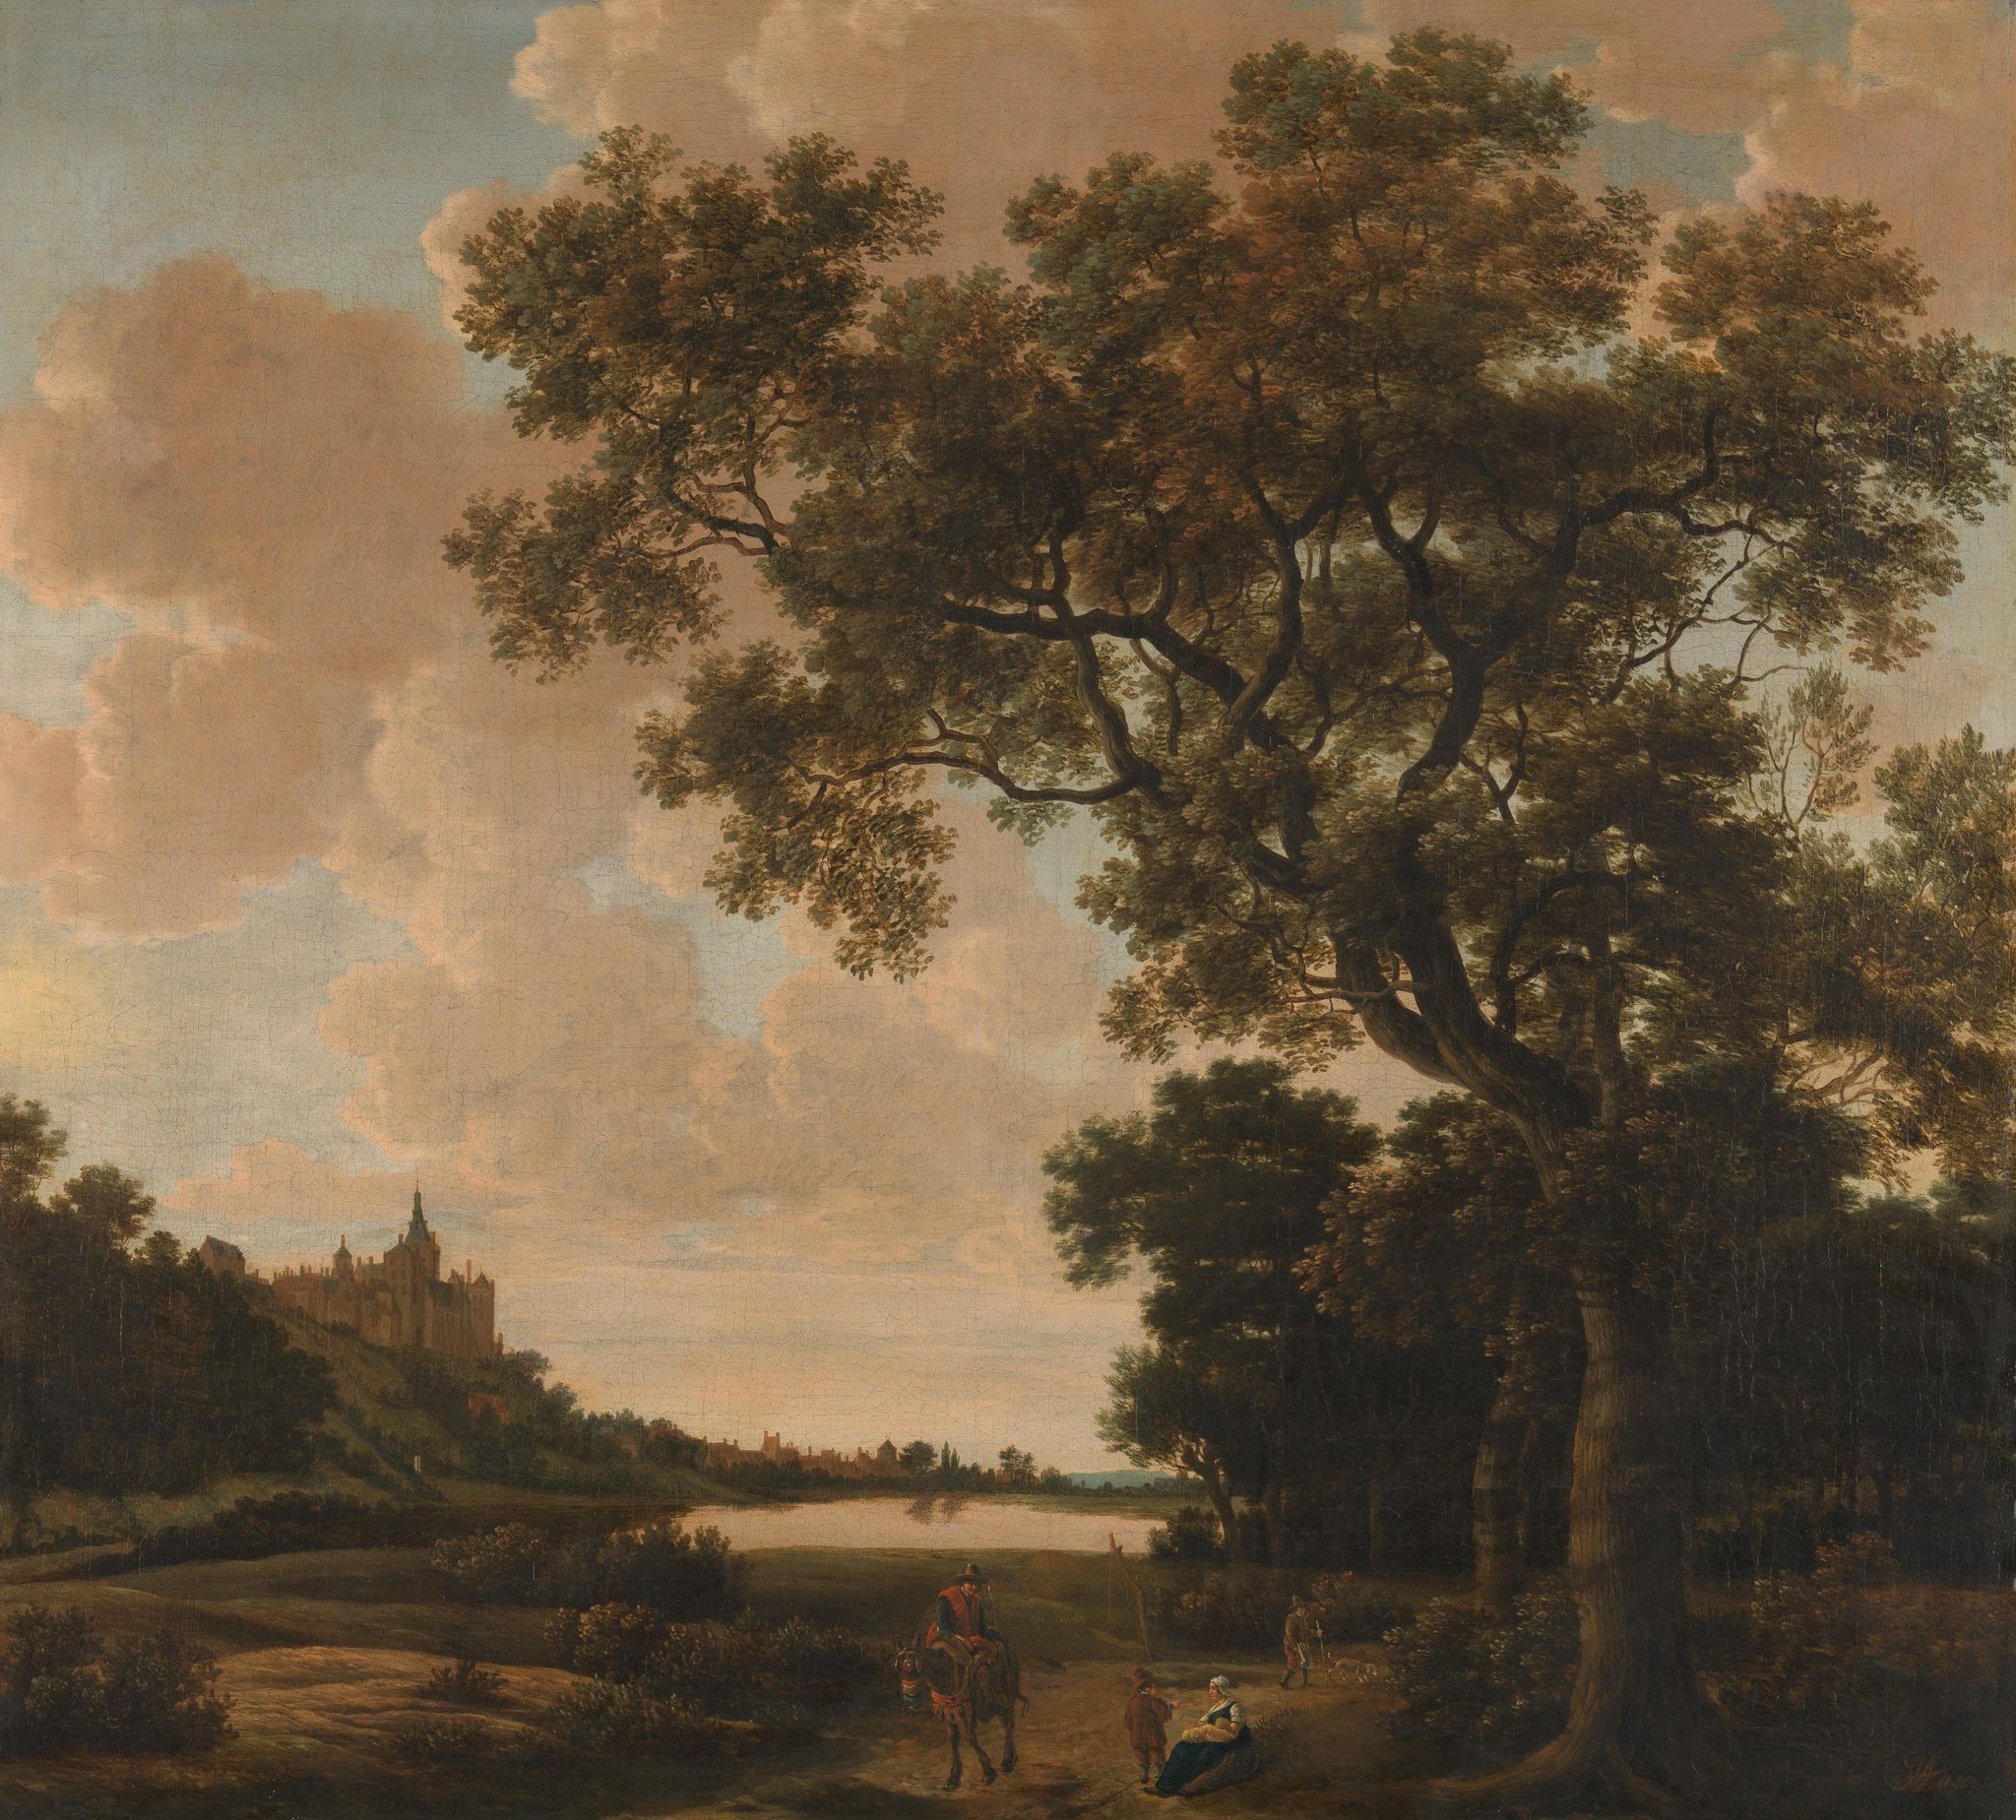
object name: painting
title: Landscape with the Schwanenburg, Cleves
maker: joris van der haagen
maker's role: draughtsman, painter, print maker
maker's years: 1615-1669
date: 1650-1655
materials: canvas, oil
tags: landscape with tower or castle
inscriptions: signature, lower right (J, V and H ligated): ‘JVHagen’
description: Landschap met een gezicht vanuit een bos op de Zwanenburcht te Kleef. Op de voorgrond een man op een muilezel en verschillende figuren op een weg.